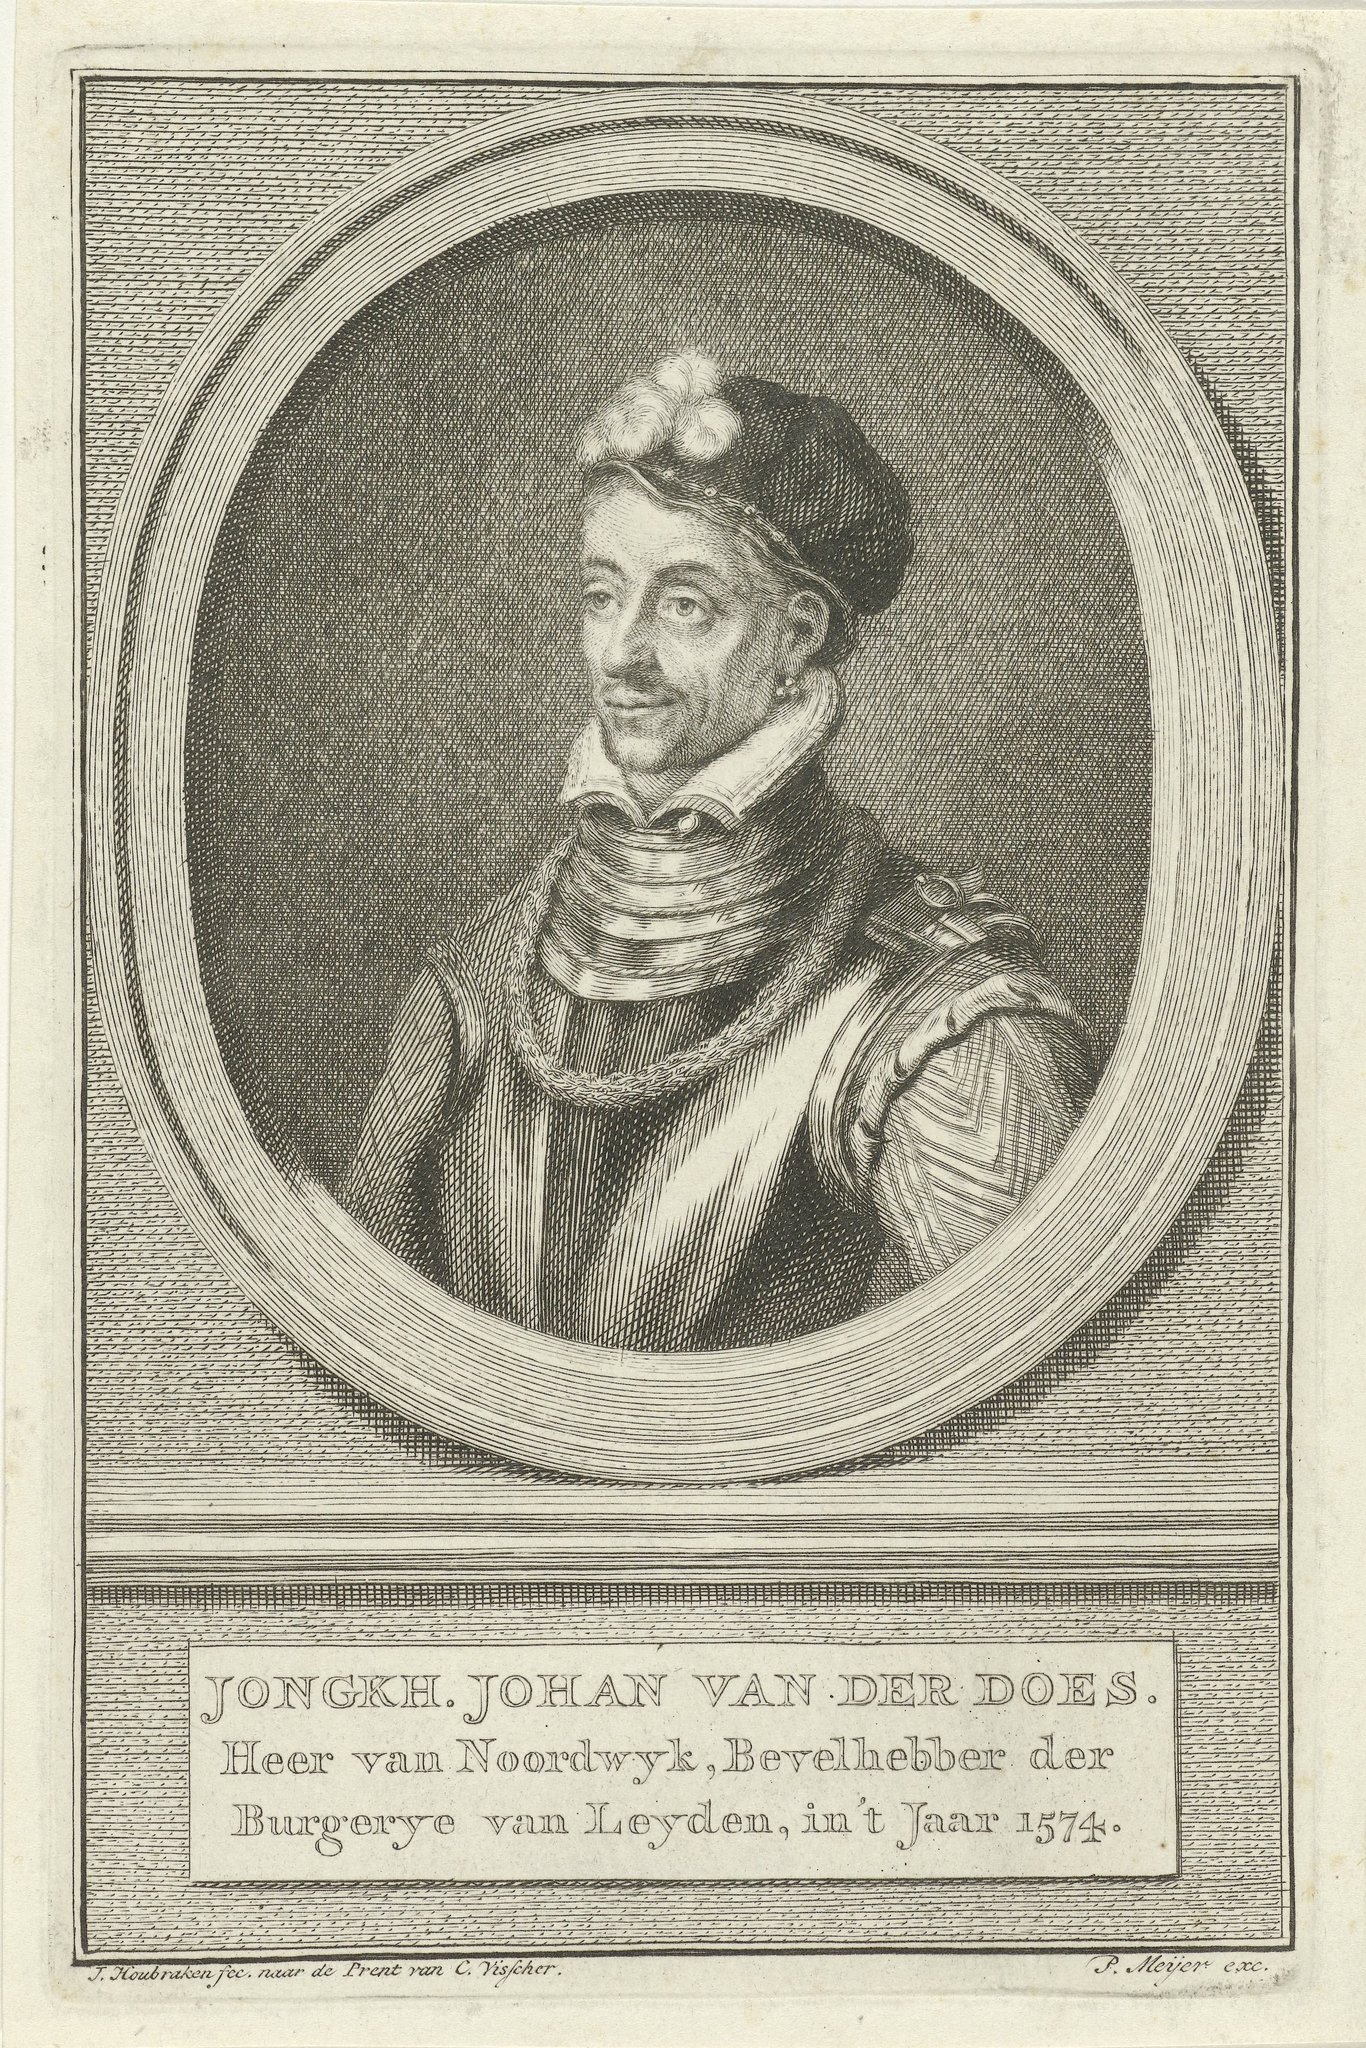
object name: print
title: Portret van Johan van der Does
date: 1774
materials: paper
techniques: engraving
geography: amsterdam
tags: bevelhebber, dichter, filoloog, bibliothecaris, bestuurder, jan van der does (heer van noordwijk en kattendijke)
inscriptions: collector's mark: Lugt 2228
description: Prent volgens Ver Huell ook gebruikt in: Lucretia Wilhelmina van Winter geboren van Merken, Het beleg der stad Leyden. Treurspel. Amsterdam: Pieter Meijer, 1774. Variant in spiegelbeeld, van latere datum, van de prent gebruikt in: Jan Wagenaar, Vaderlandsche historie, vervattende de geschiedenissen der nu Vereenigde Nederlanden, inzonderheid die van Holland (...), 21 delen. Amsterdam, Isaak Tirion, 1749-59.